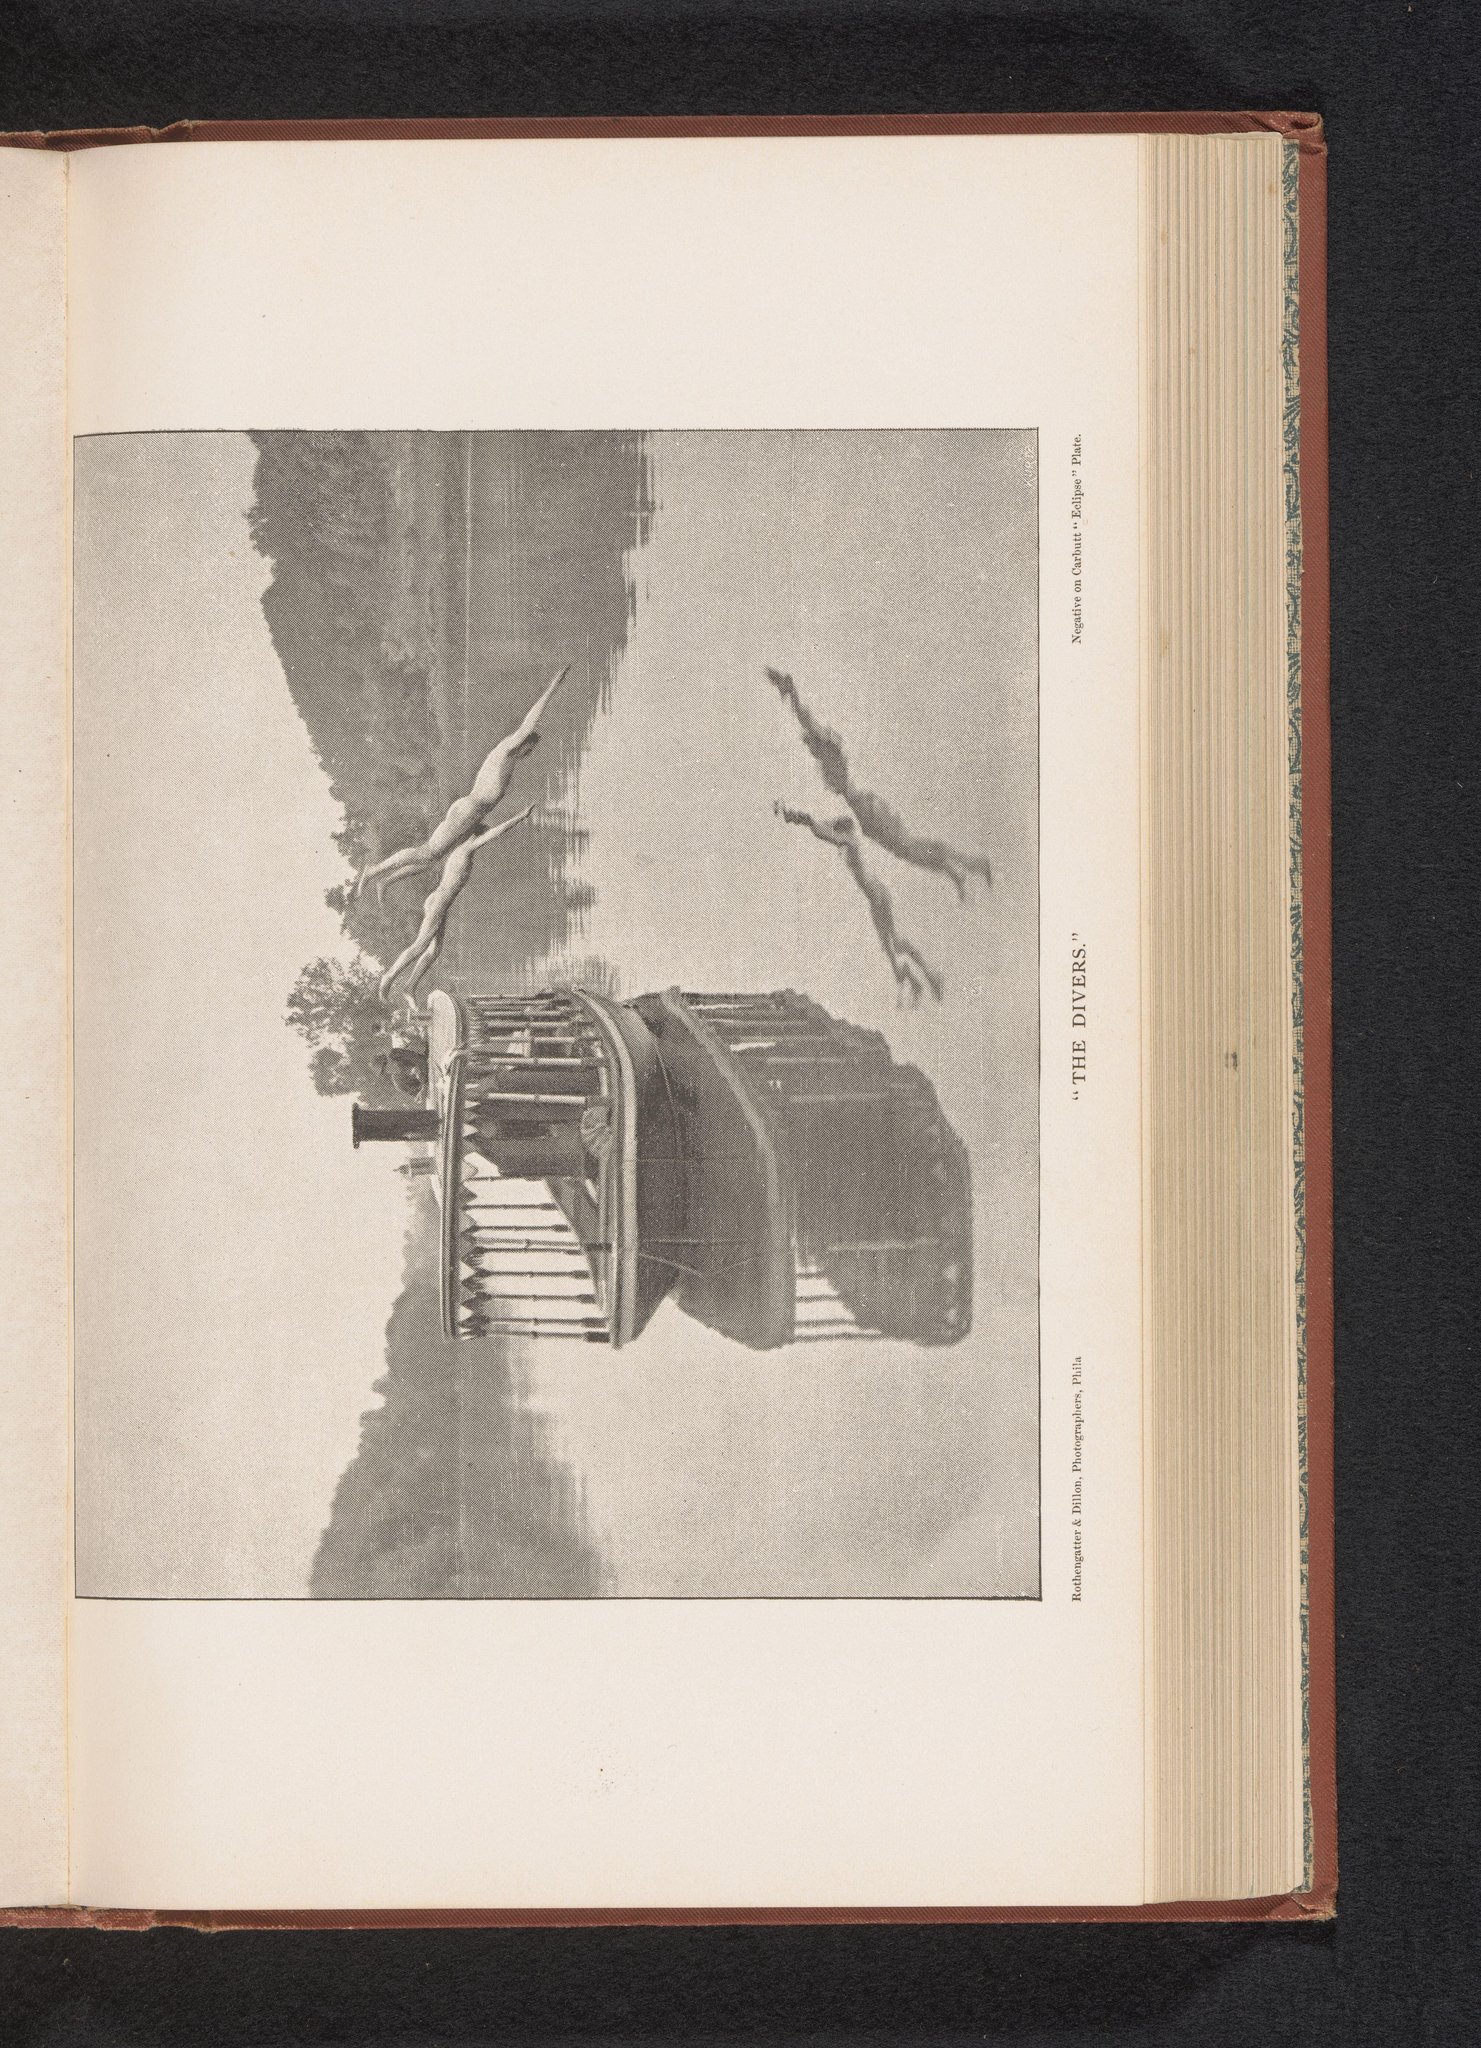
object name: page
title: Twee mannen duiken van een boot het water in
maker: Anonymous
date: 1884-1889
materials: paper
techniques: autotype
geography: north and central america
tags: diving (movement in water), adult man, steamship, motorship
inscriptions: name: ‘Kurtz’, inscription: ‘Negative on Carbutt "Eclipse" Plate.’